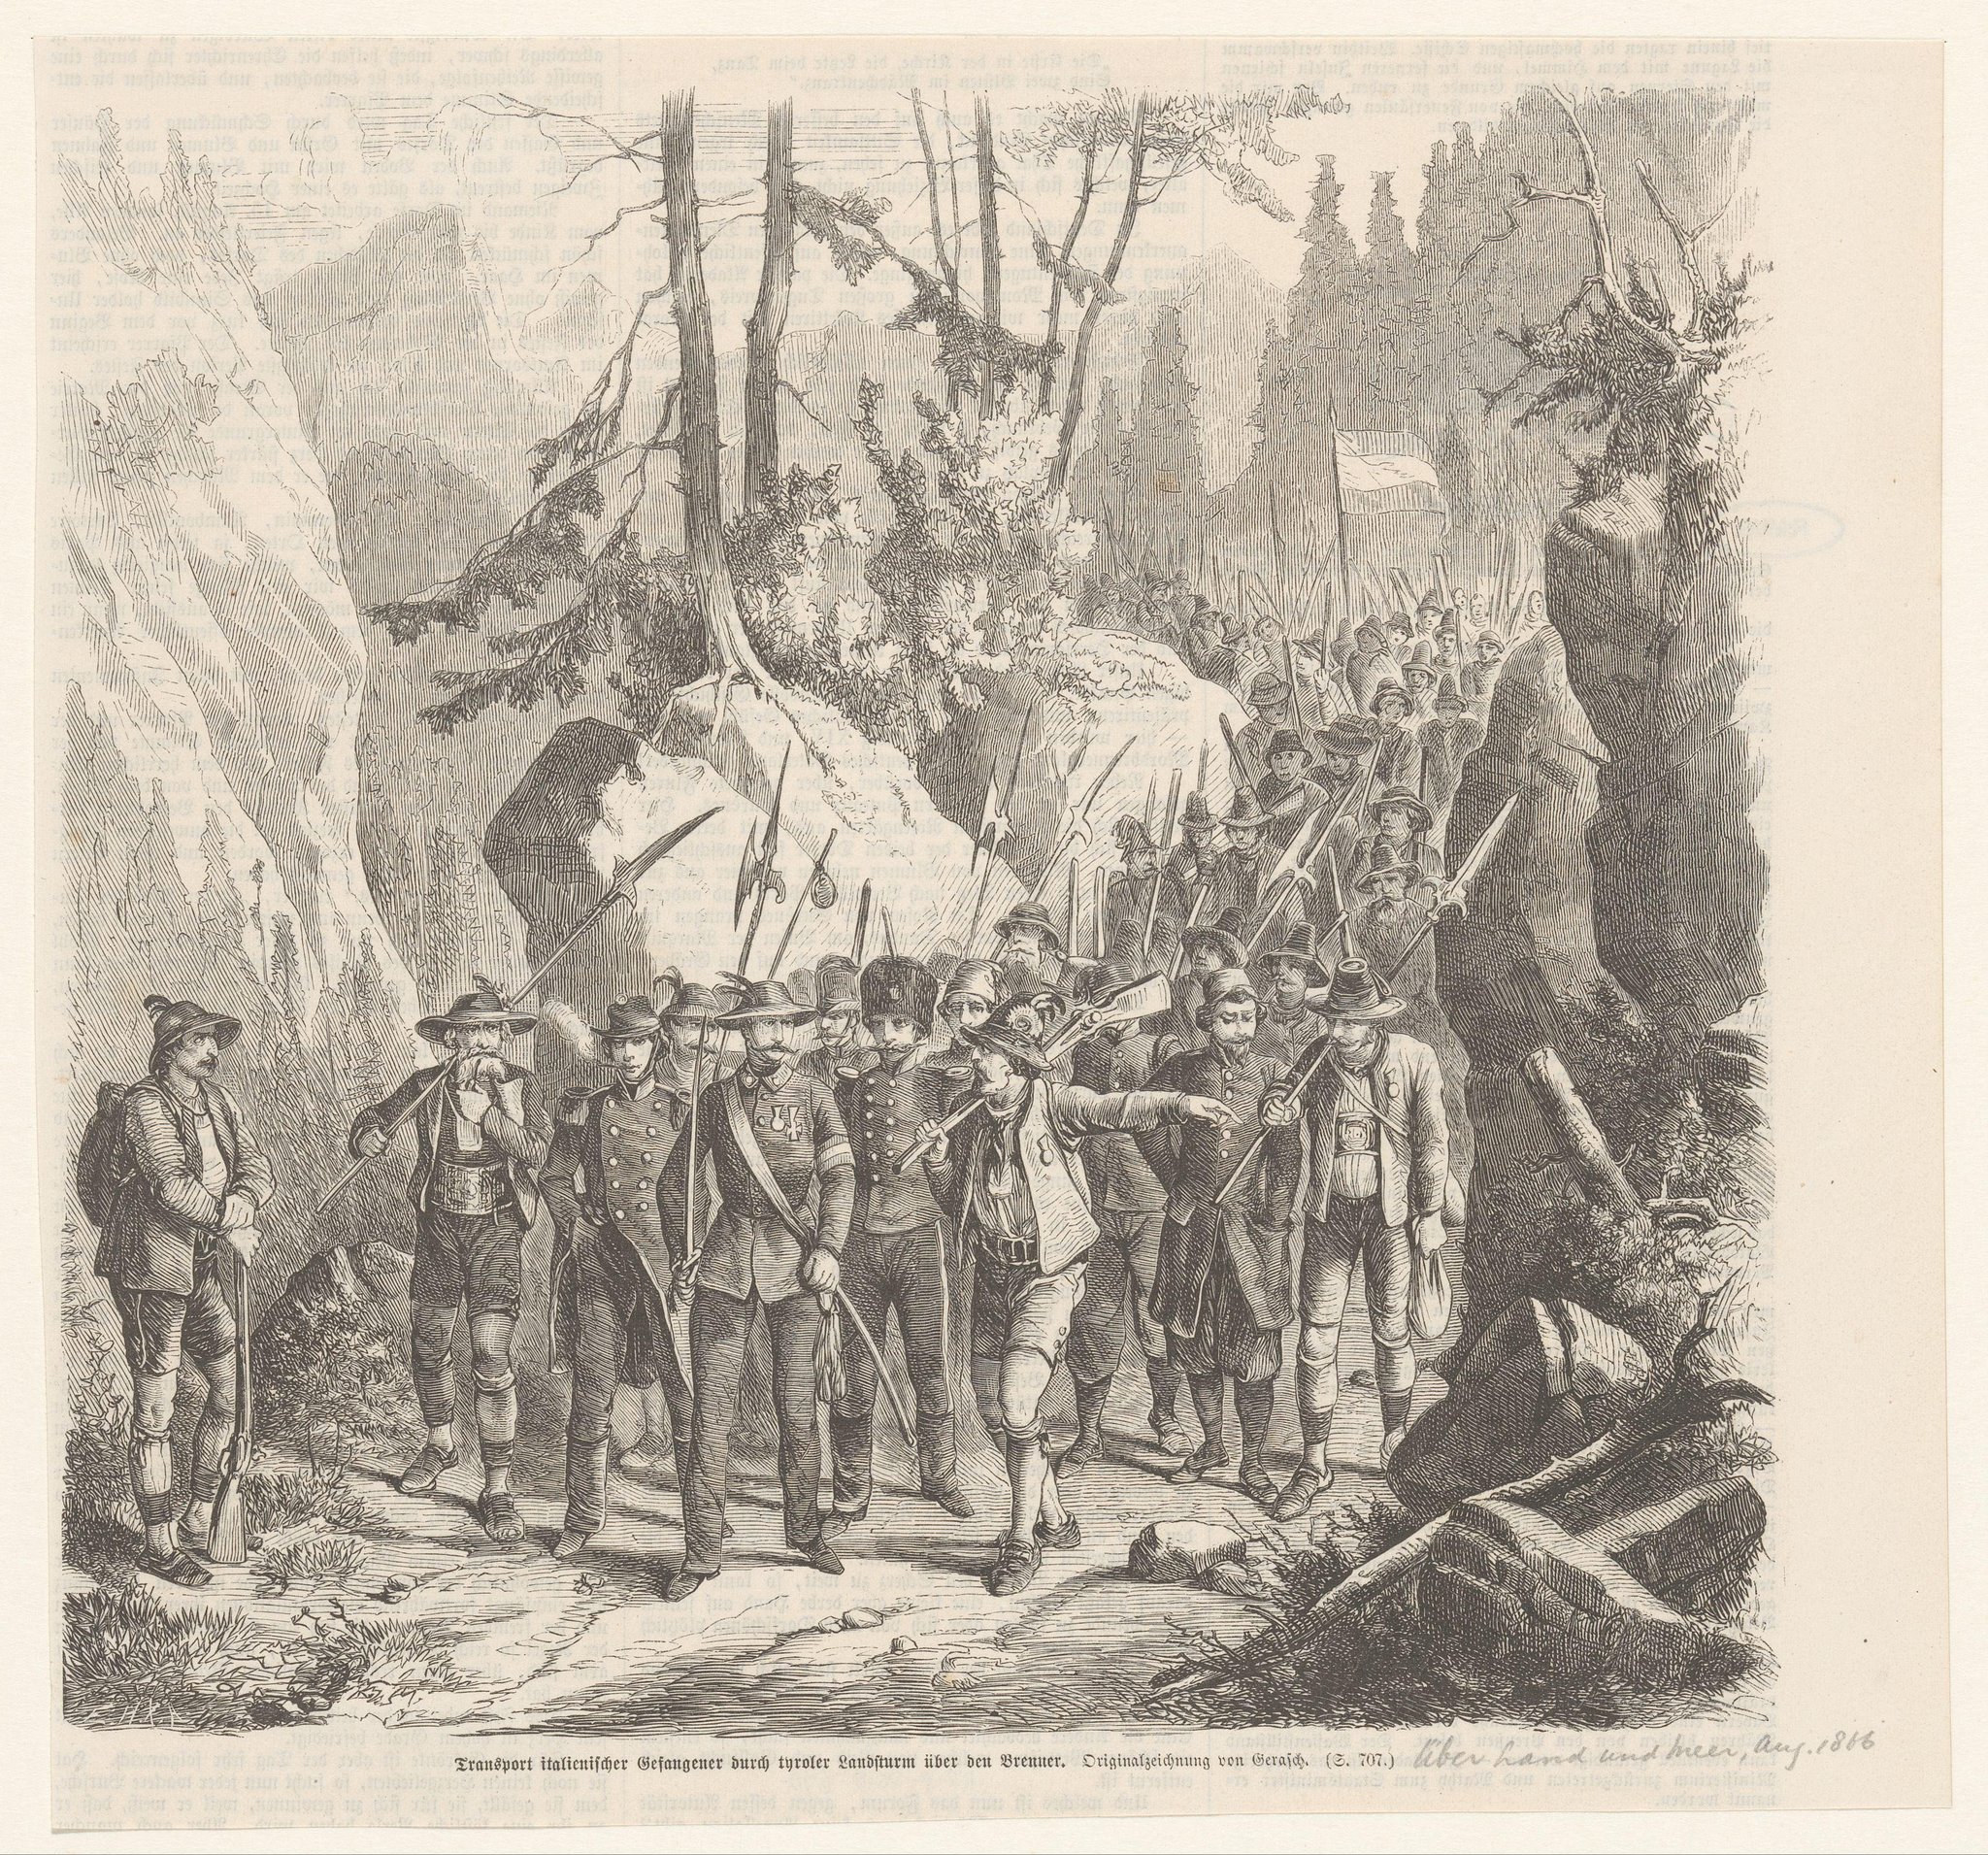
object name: print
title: Transport italienischer Gefangener durch tyroler Landsturm über den Brenner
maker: Anonymous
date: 1808-1866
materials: paper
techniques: engraving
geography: germany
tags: transfer, deportation ~ prisoner of war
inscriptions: collector's mark: Lugt 2228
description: Transport door de Oostenrijkse Landsturm van Italiaanse krijgsgevangenen door de Brennerpas, 1866. Scène uit de Pruisisch-Oostenrijkse Oorlog.